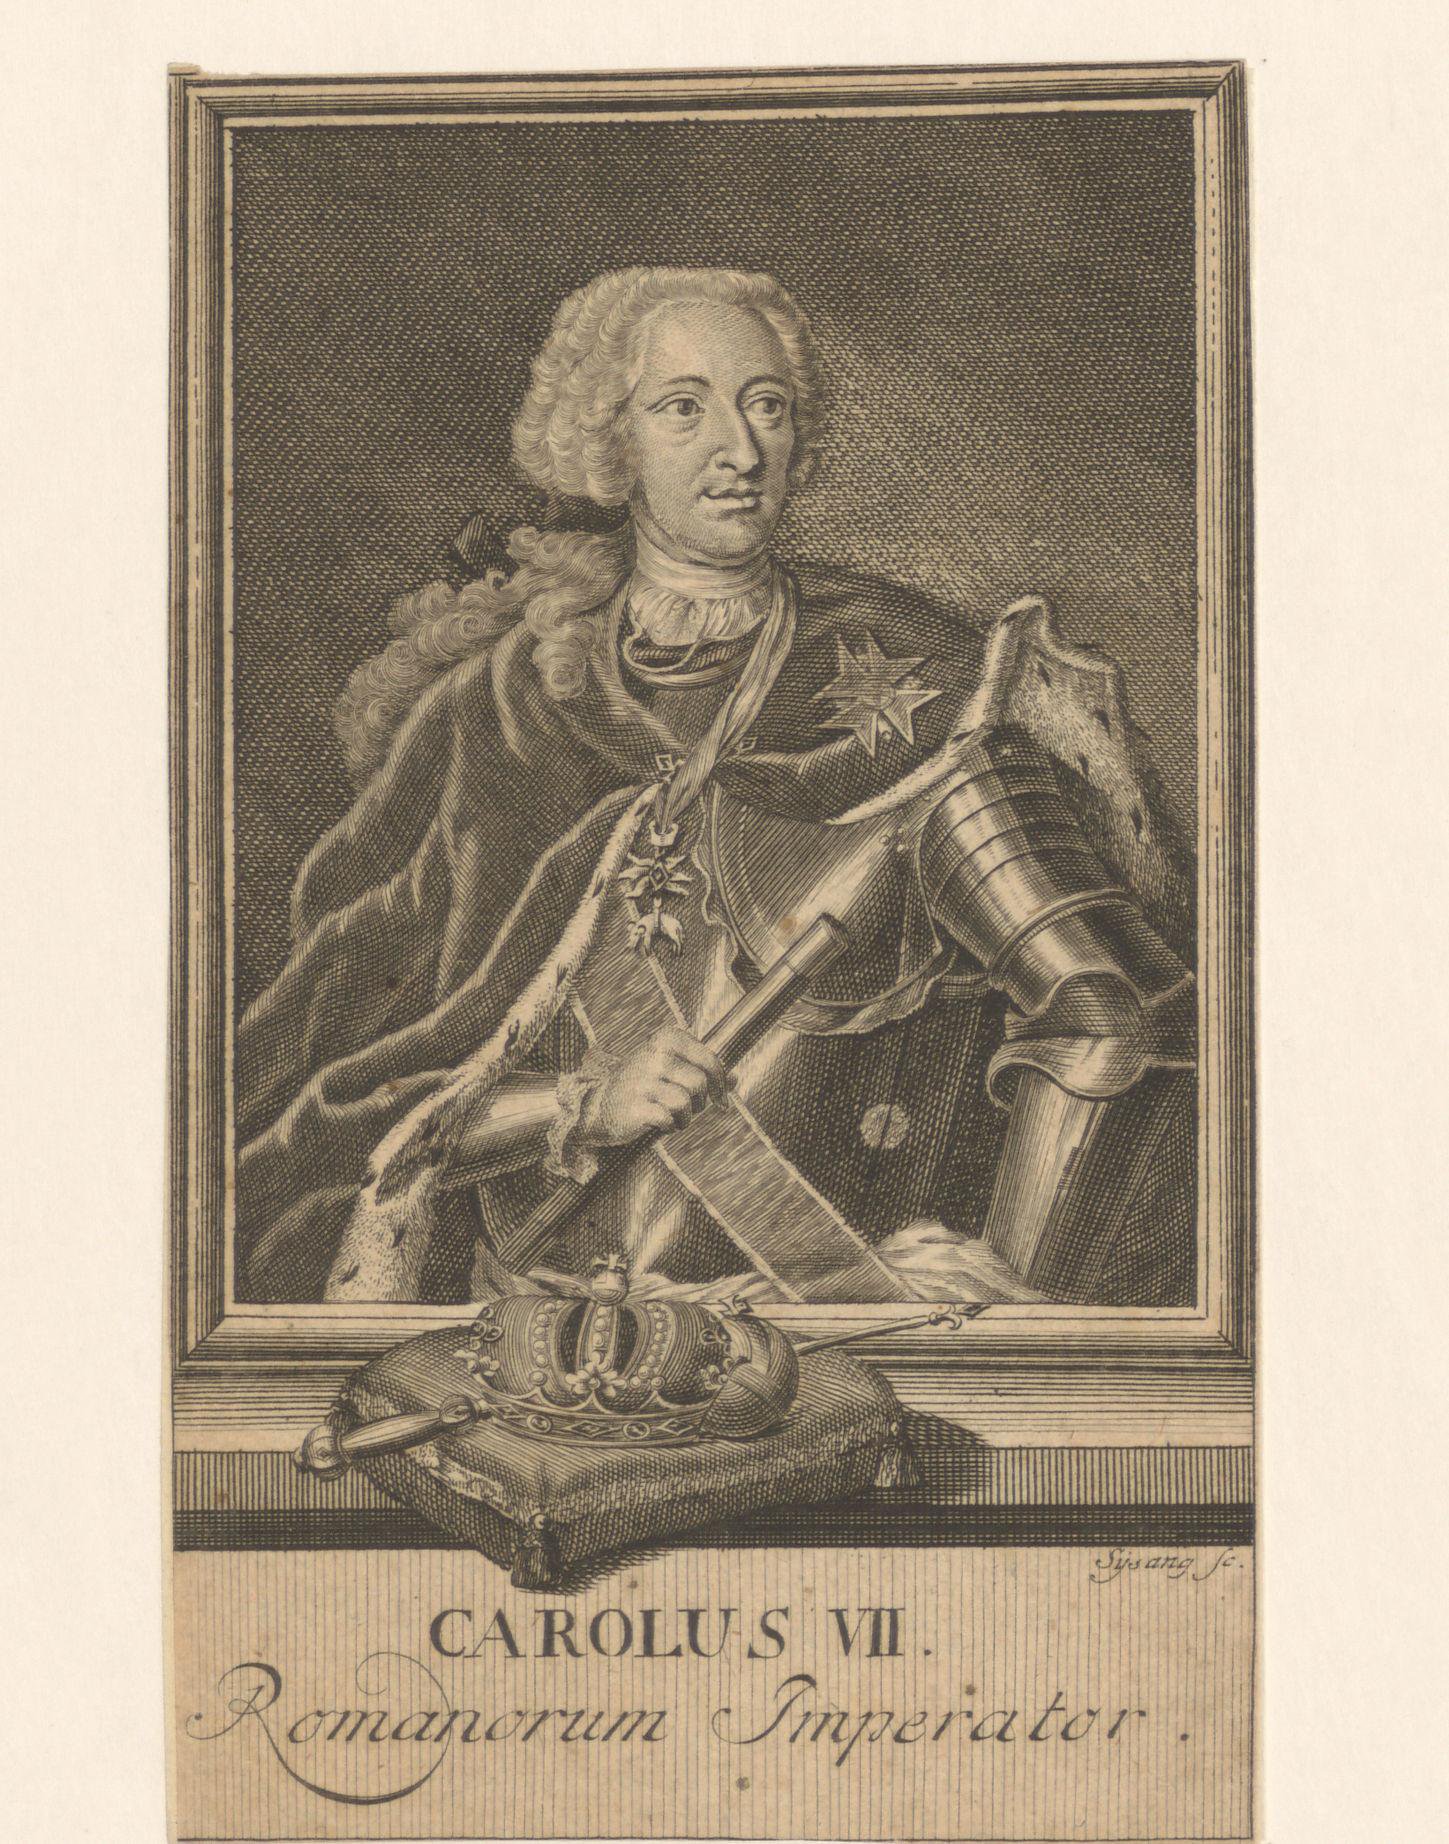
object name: print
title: Portret van Karel VII Albrecht, Duits keizer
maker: johann christoph sysang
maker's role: print maker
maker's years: 1703-1757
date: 1742-1757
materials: paper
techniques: engraving, etching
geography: leipzig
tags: brussels, karel vii albrecht (duits keizer), armour, historical persons, knighthood order of the golden fleece - insignia of a knighthood order, e.g.: badge, chain (with name of order), baton of general, insignia and symbols of sovereignty (crown, diadem, sceptre, orb, seal, standard, cloak, pectoral)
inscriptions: collector's mark: Lugt 2228